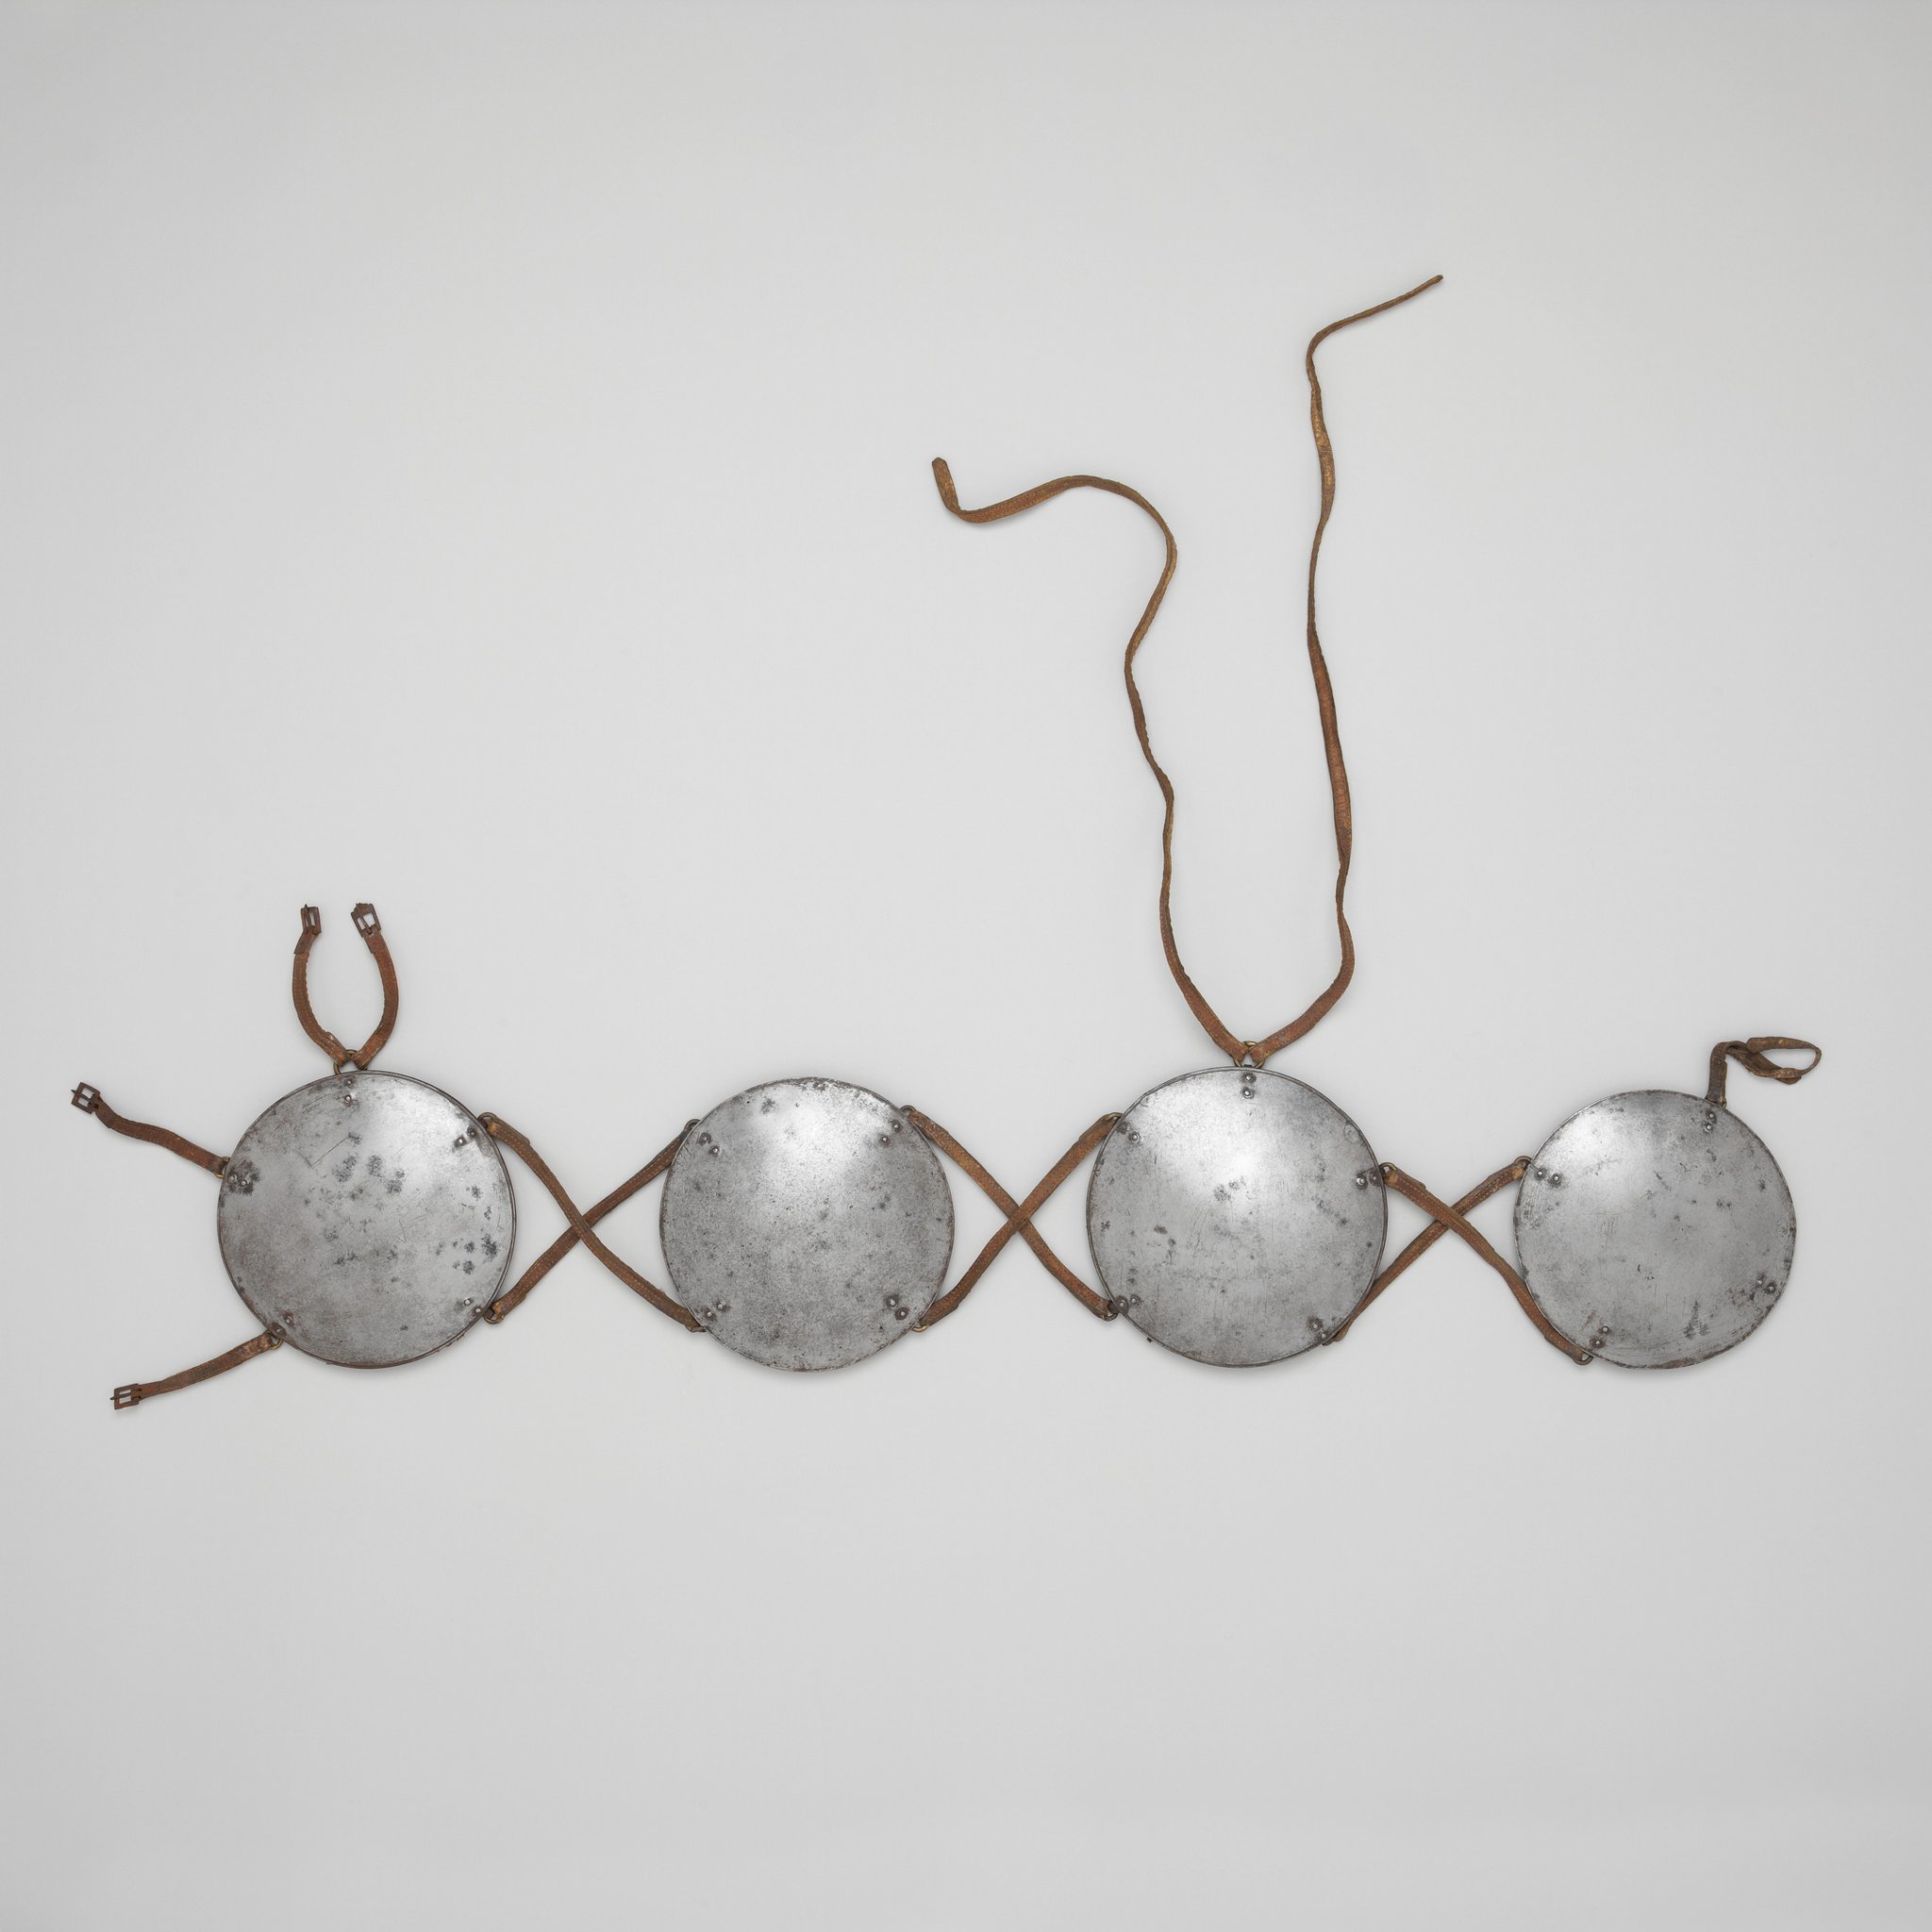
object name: set of four mirror cuirass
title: Set of Four Mirriors (Cuirass)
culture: nepalese or tibetan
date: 1701-1900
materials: iron, leather, textile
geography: nepal